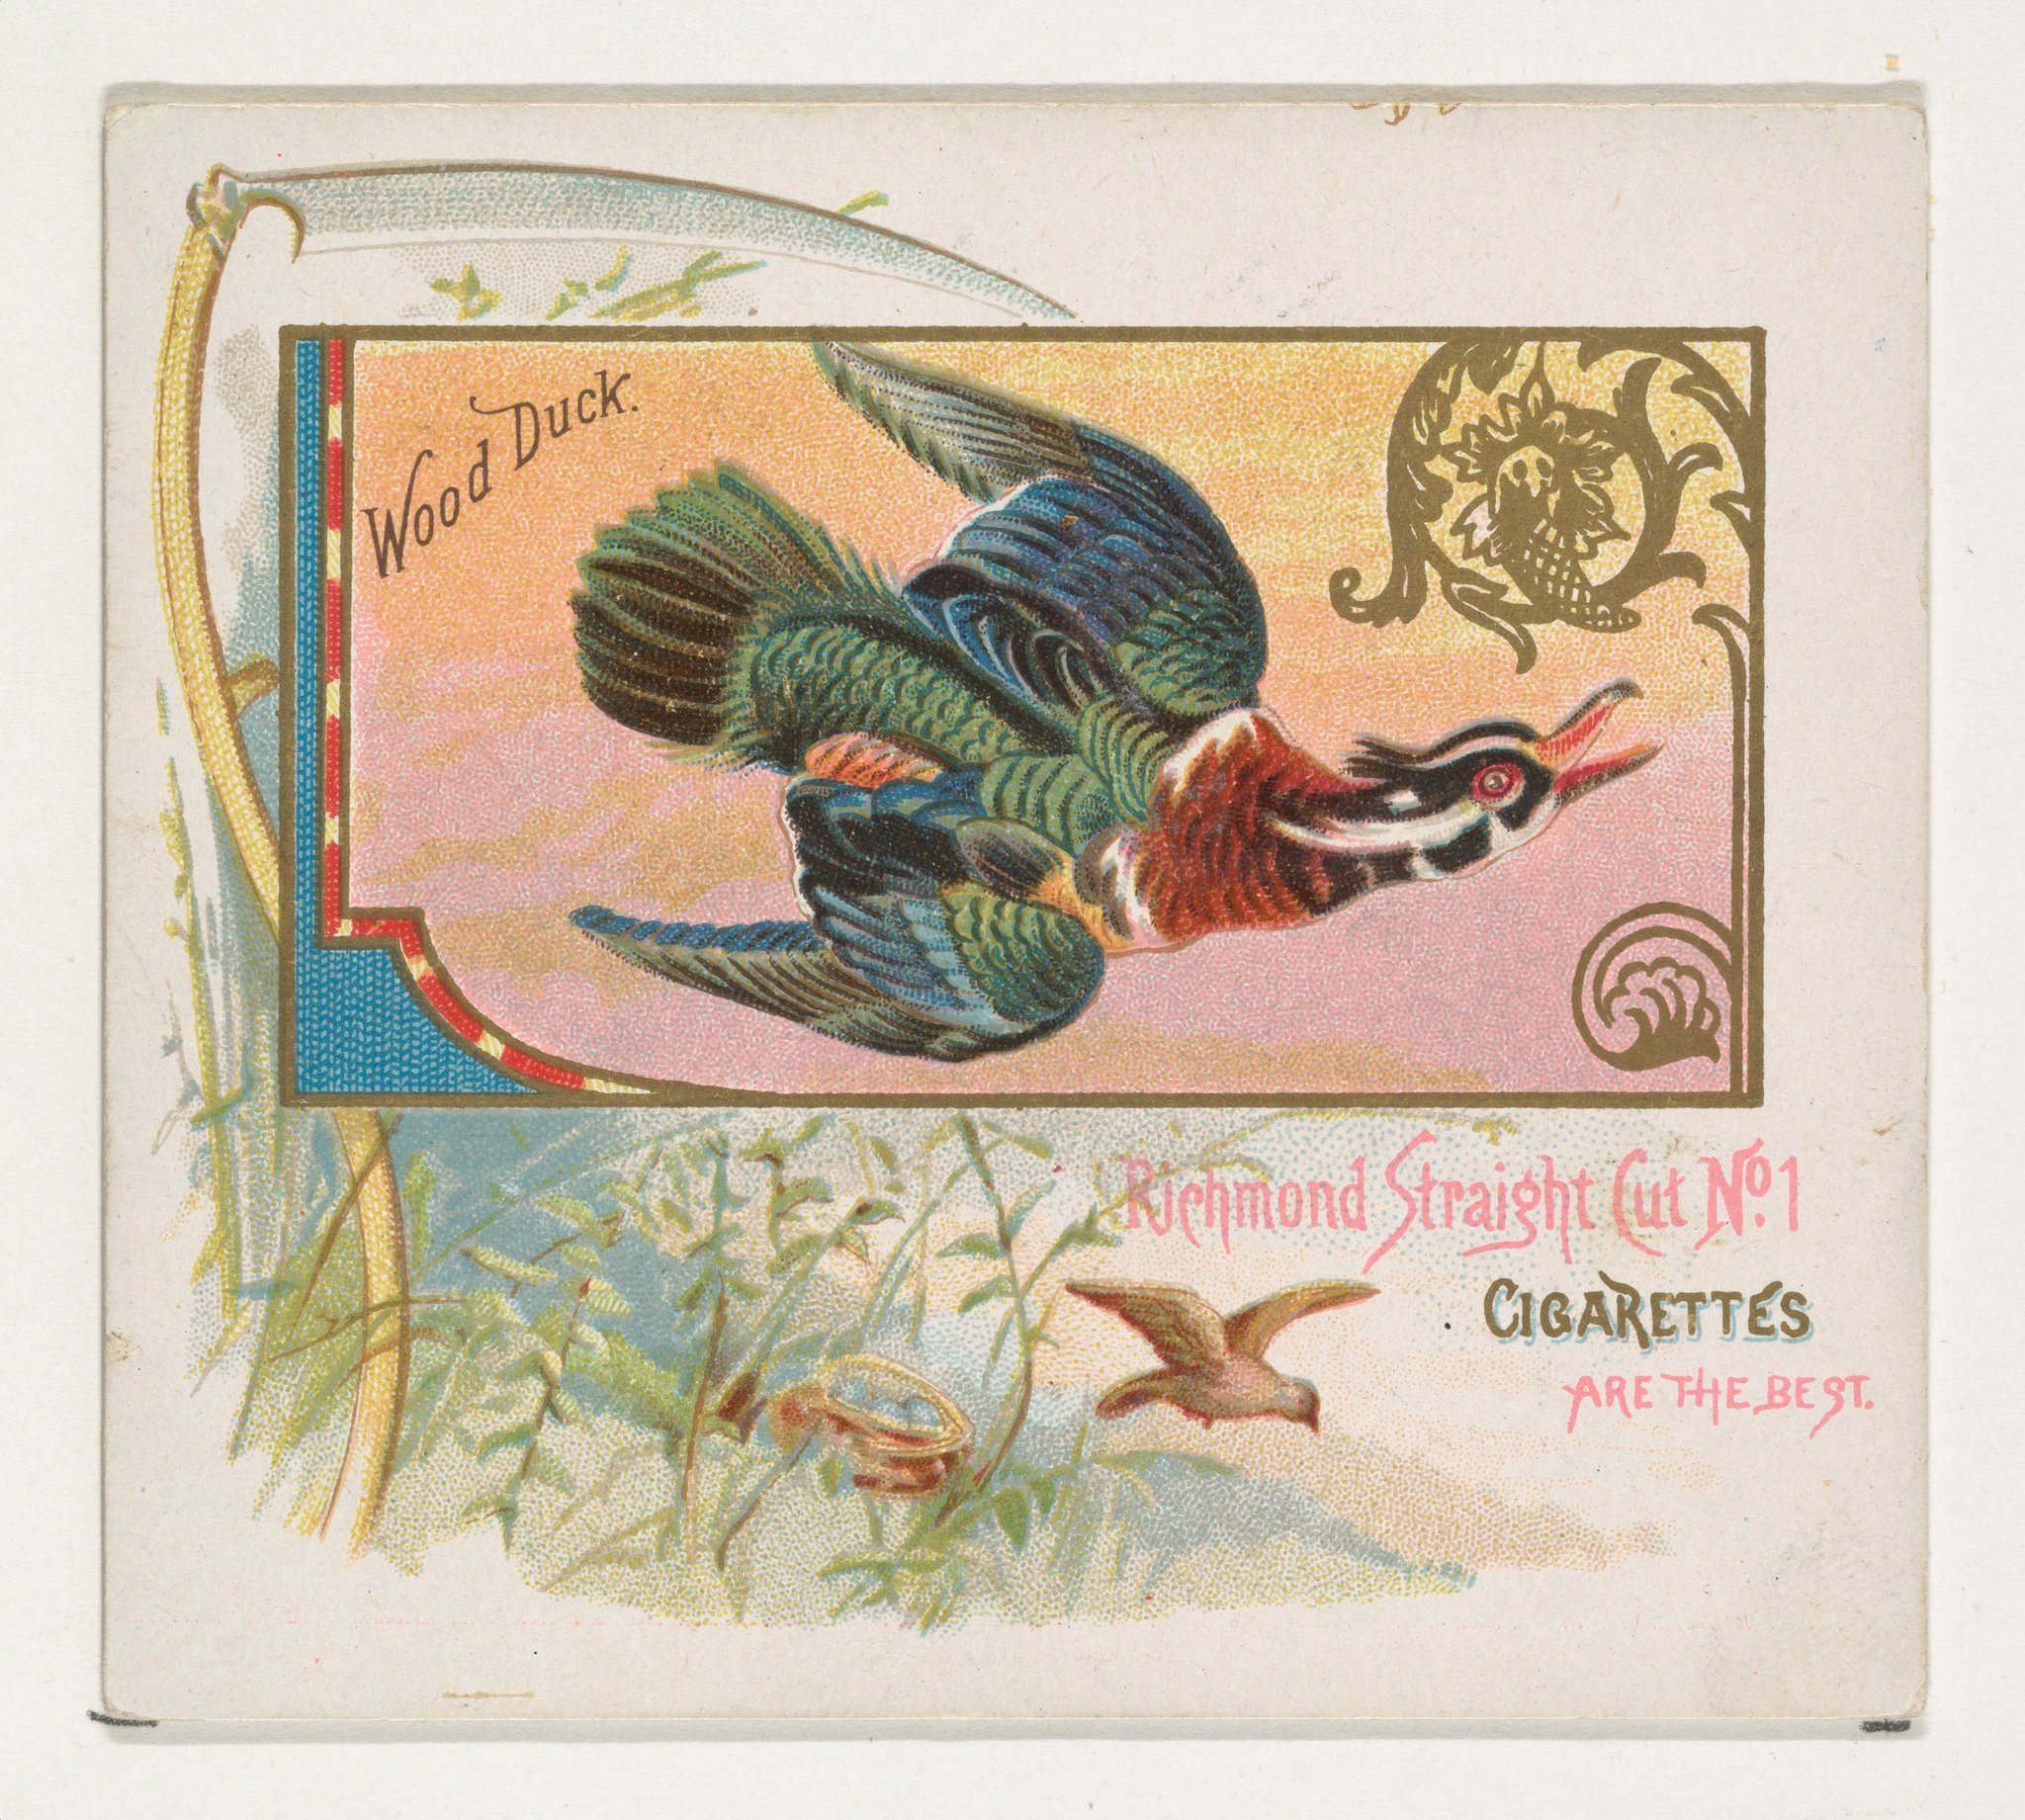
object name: print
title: Wood Duck, from the Game Birds series (N40) for Allen & Ginter Cigarettes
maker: allen & ginter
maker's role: publisher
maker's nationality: american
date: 1888-1890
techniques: color lithograph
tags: ducks